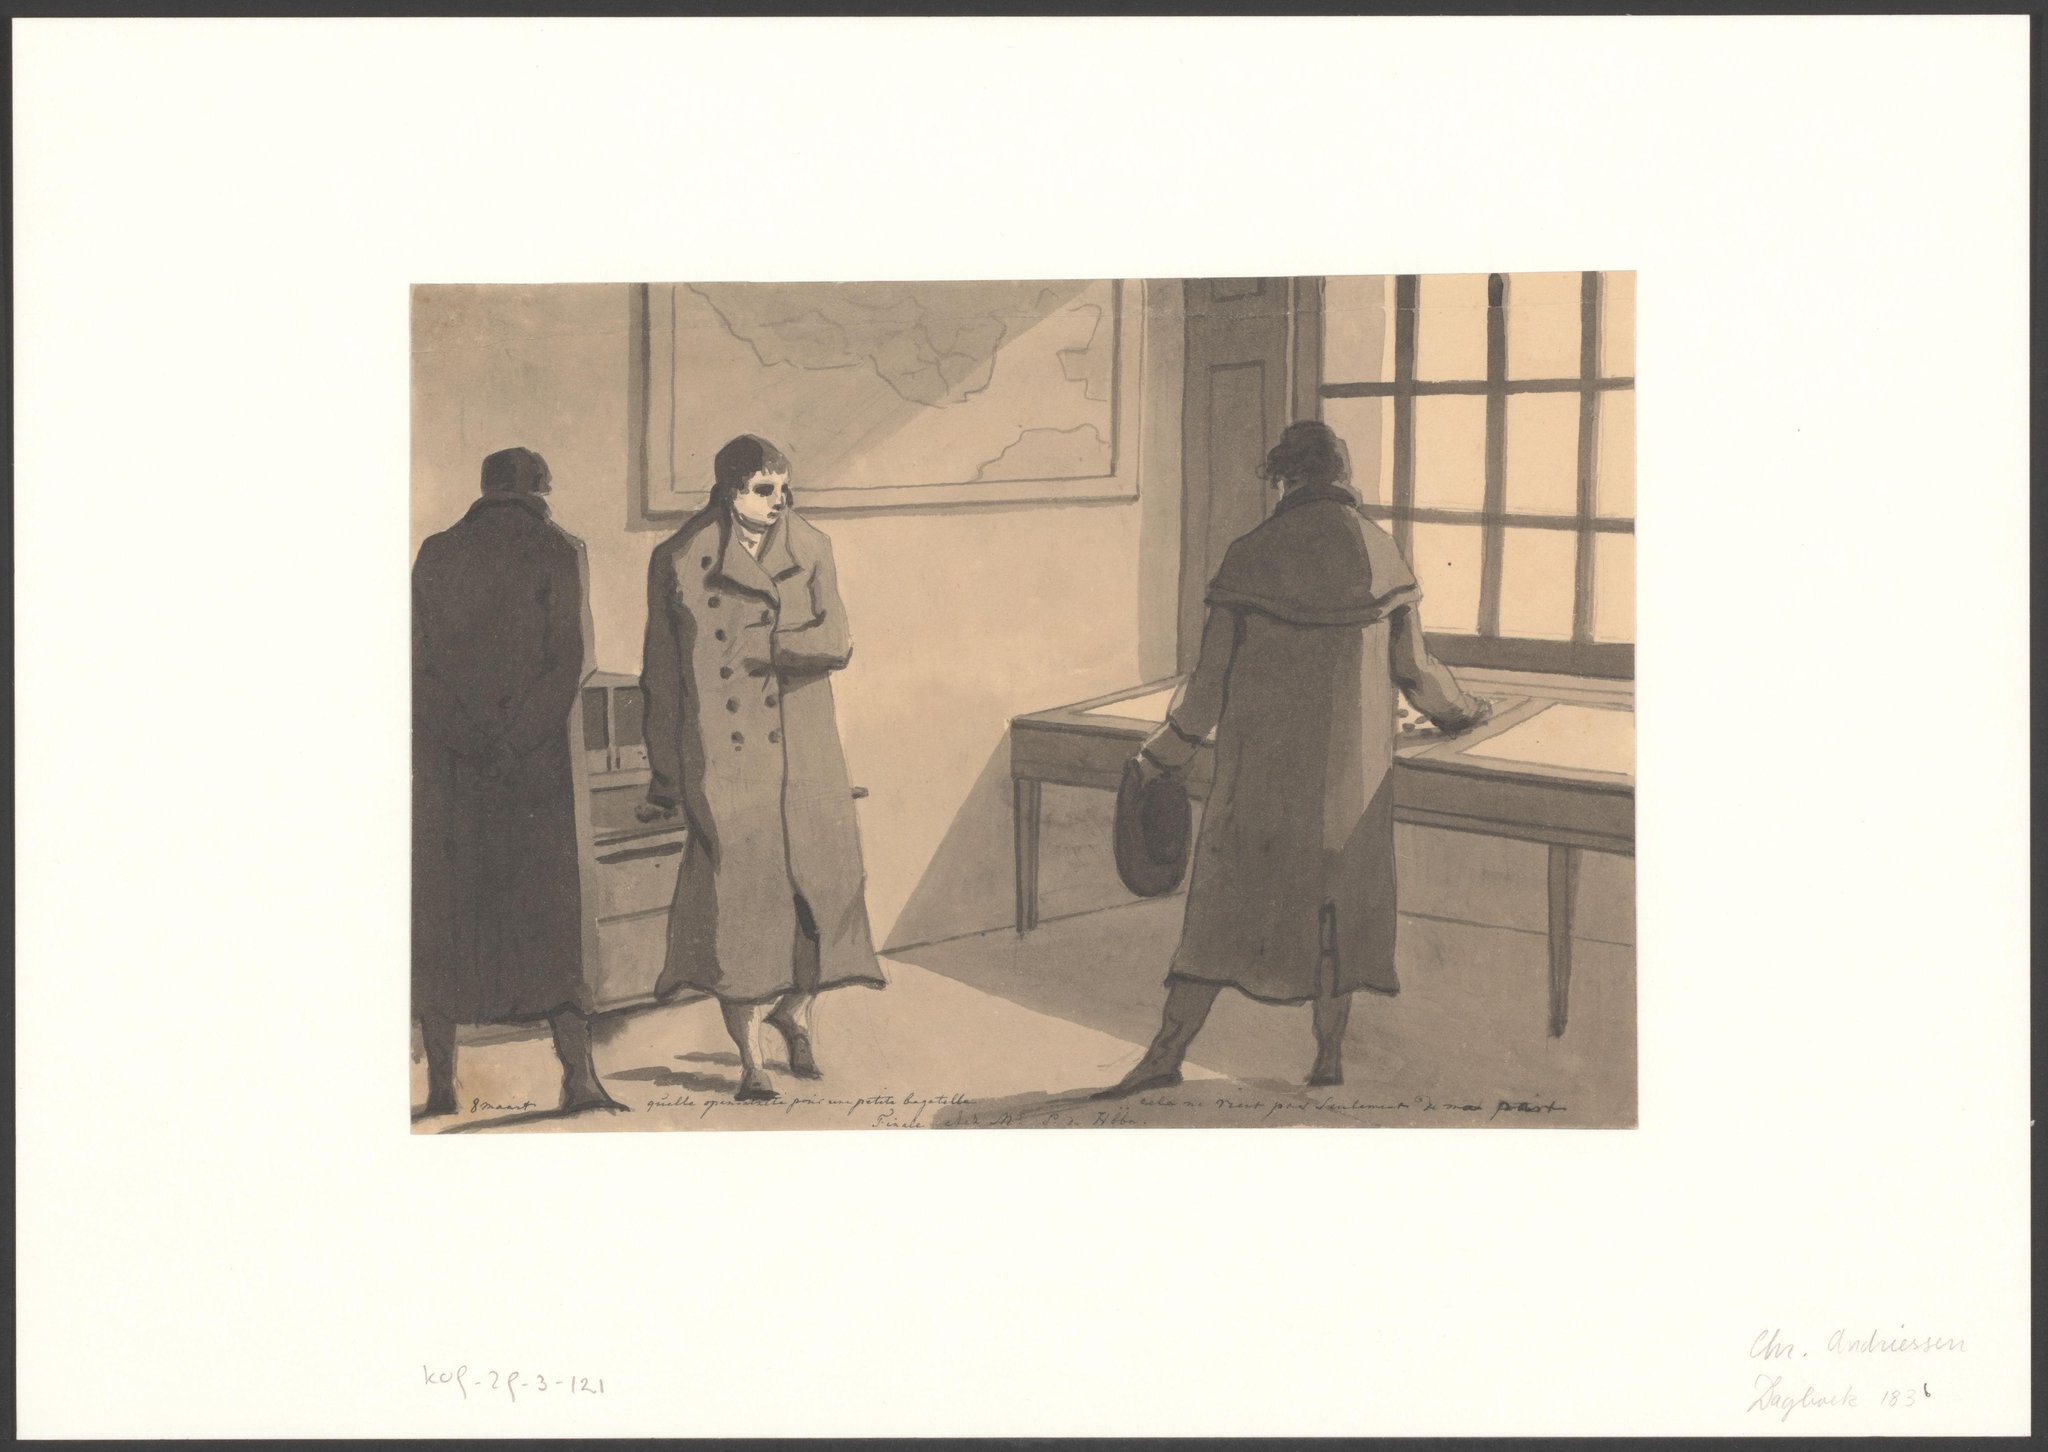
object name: print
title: Christiaan Andriessen en Pieter de Haan beëindigen de lessen van de zoons van De Haan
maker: christiaan andriessen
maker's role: draughtsman, print maker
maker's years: 1775-1846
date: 1806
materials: ink, paper, pencil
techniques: brush, pen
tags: print maker, draughtsman, christiaan andriessen, standing figure, drawing-room, 'salon'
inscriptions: signature, inscription: ‘8 maart qúelle opiniatreté pour une petite bagatelle (...)’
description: Op 8 maart 1806 komt het tot een breuk tussen Christiaan Andriessen en Pieter de Haan, aan wiens zoontjes Christiaan les gaf. Een eerdere discussie over verhoging van de vergoeding speelde zich af op 21 februari.